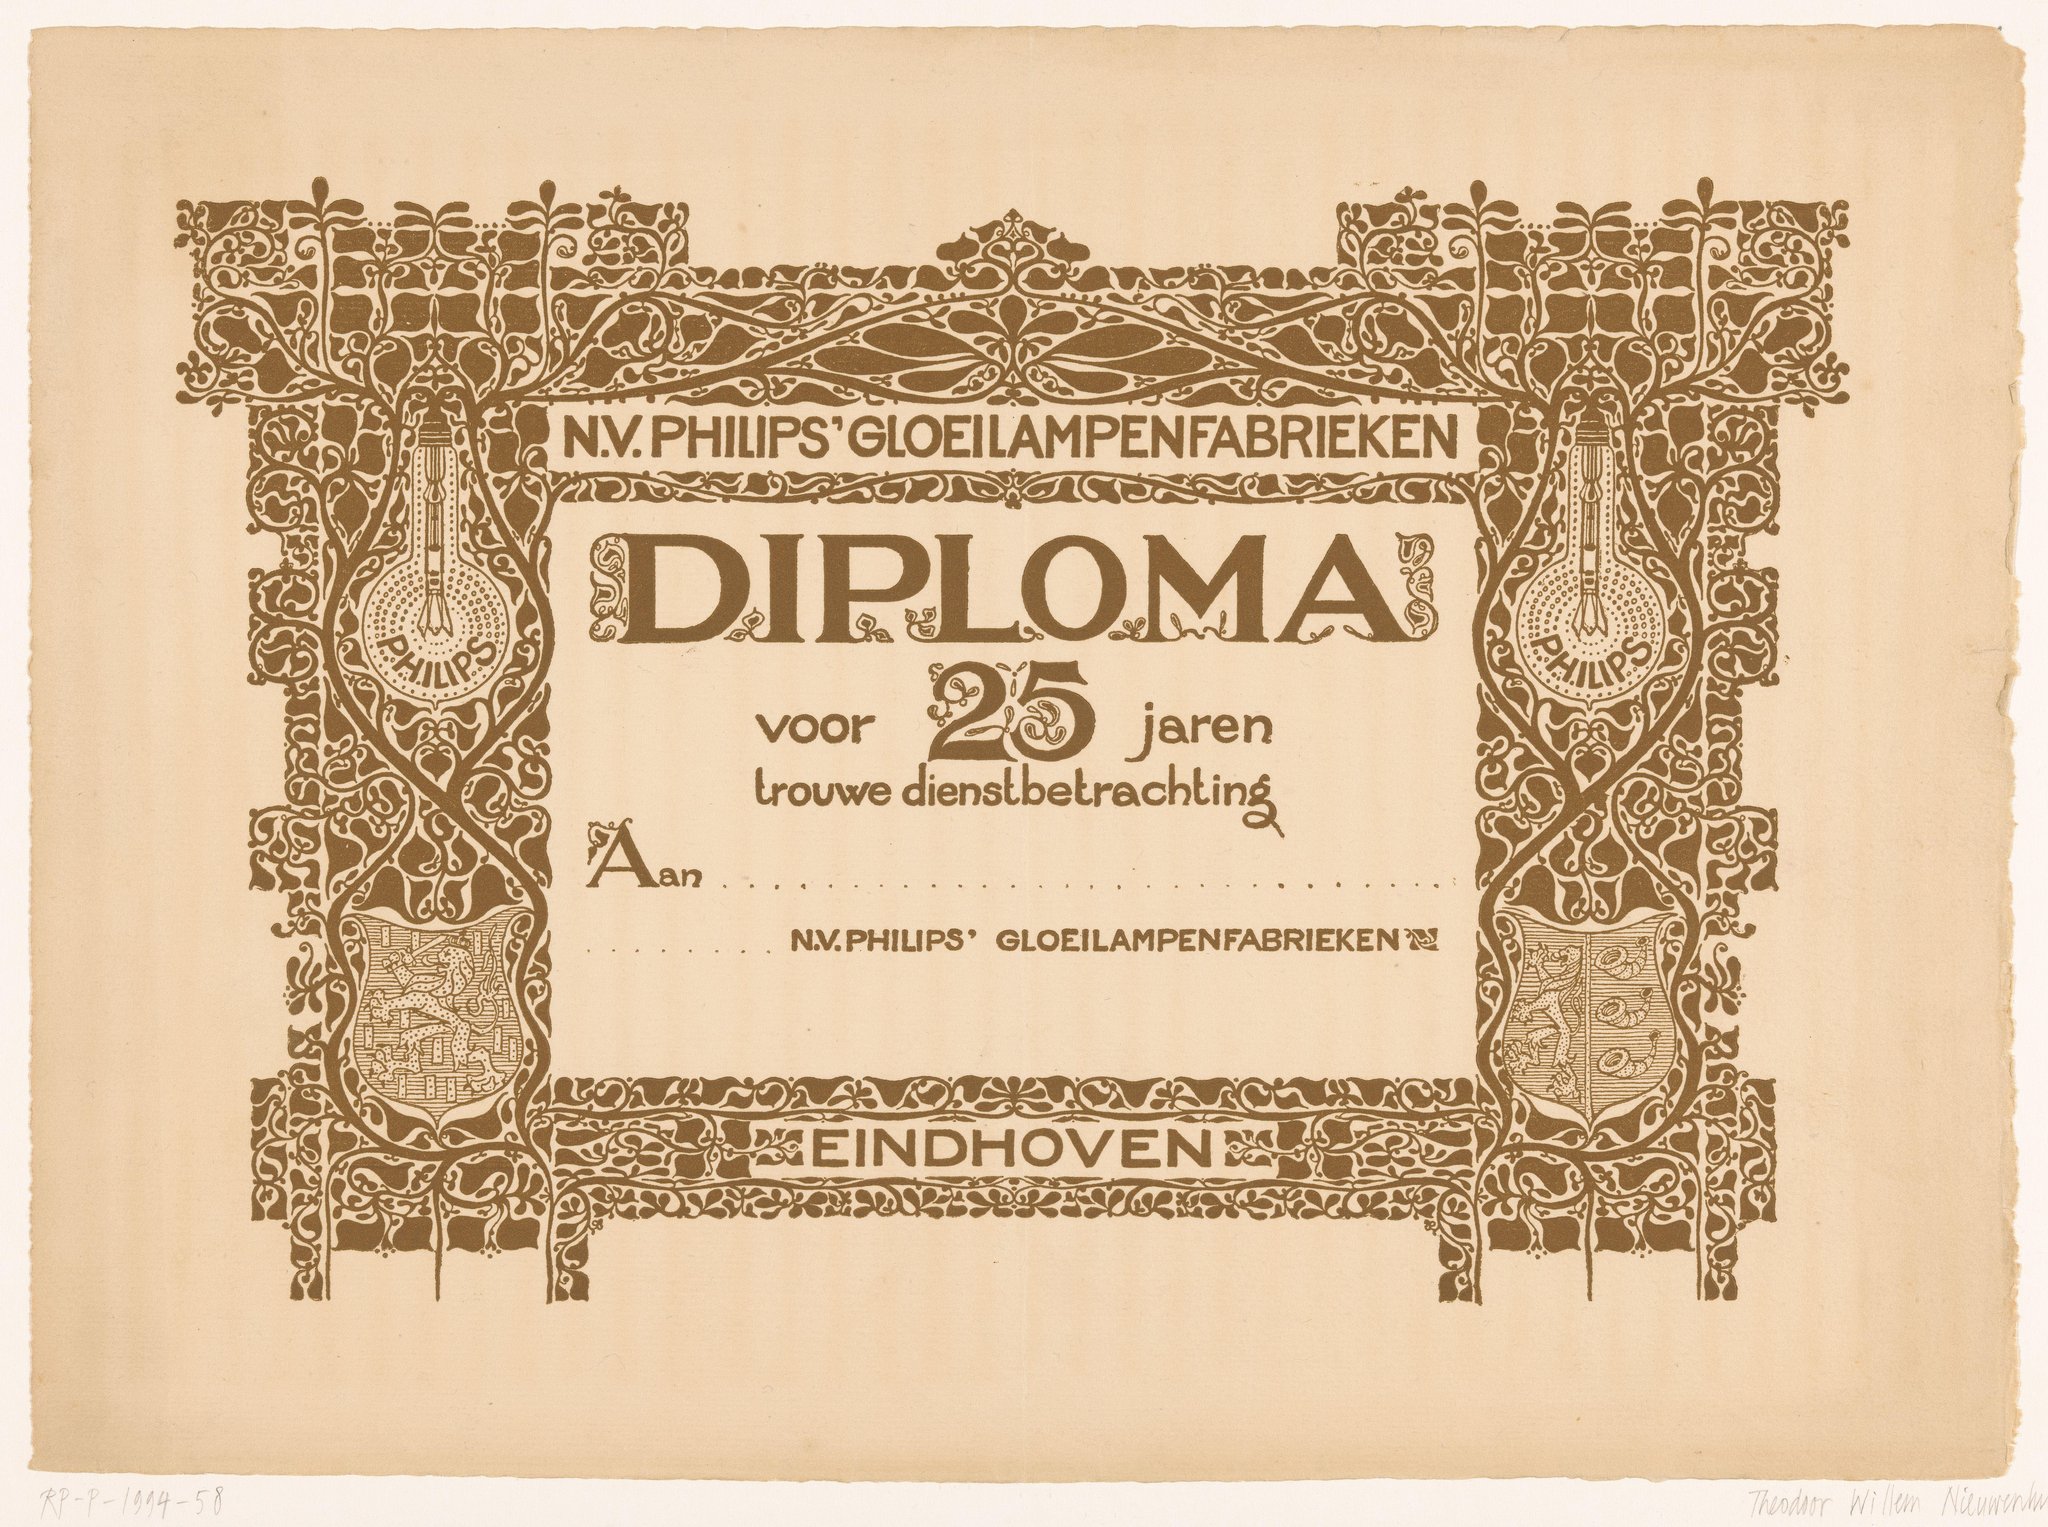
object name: certificate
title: Diploma voor vijfentwintig jaar dienst bij Philips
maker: theo nieuwenhuis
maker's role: designer, draughtsman, print maker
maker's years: 1866-1951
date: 1916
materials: paper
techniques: printing block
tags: light bulb (electric), ornament derived from plant forms, armorial bearing, heraldry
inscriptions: collector's mark: Lugt 2228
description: Een rechthoekig kader met links- en rechtsboven een Philips gloeilamp en links- en rechtsonder twee wapens. In het midden, in het kader, de tekst 'N.V. Philips' Gloeilampenfabrieken, Diploma voor 25 jaren trouwe dienstbetrachting, Aan: [...], N.V. Philips' Gloeilampenfabrieken, Eindhoven'.